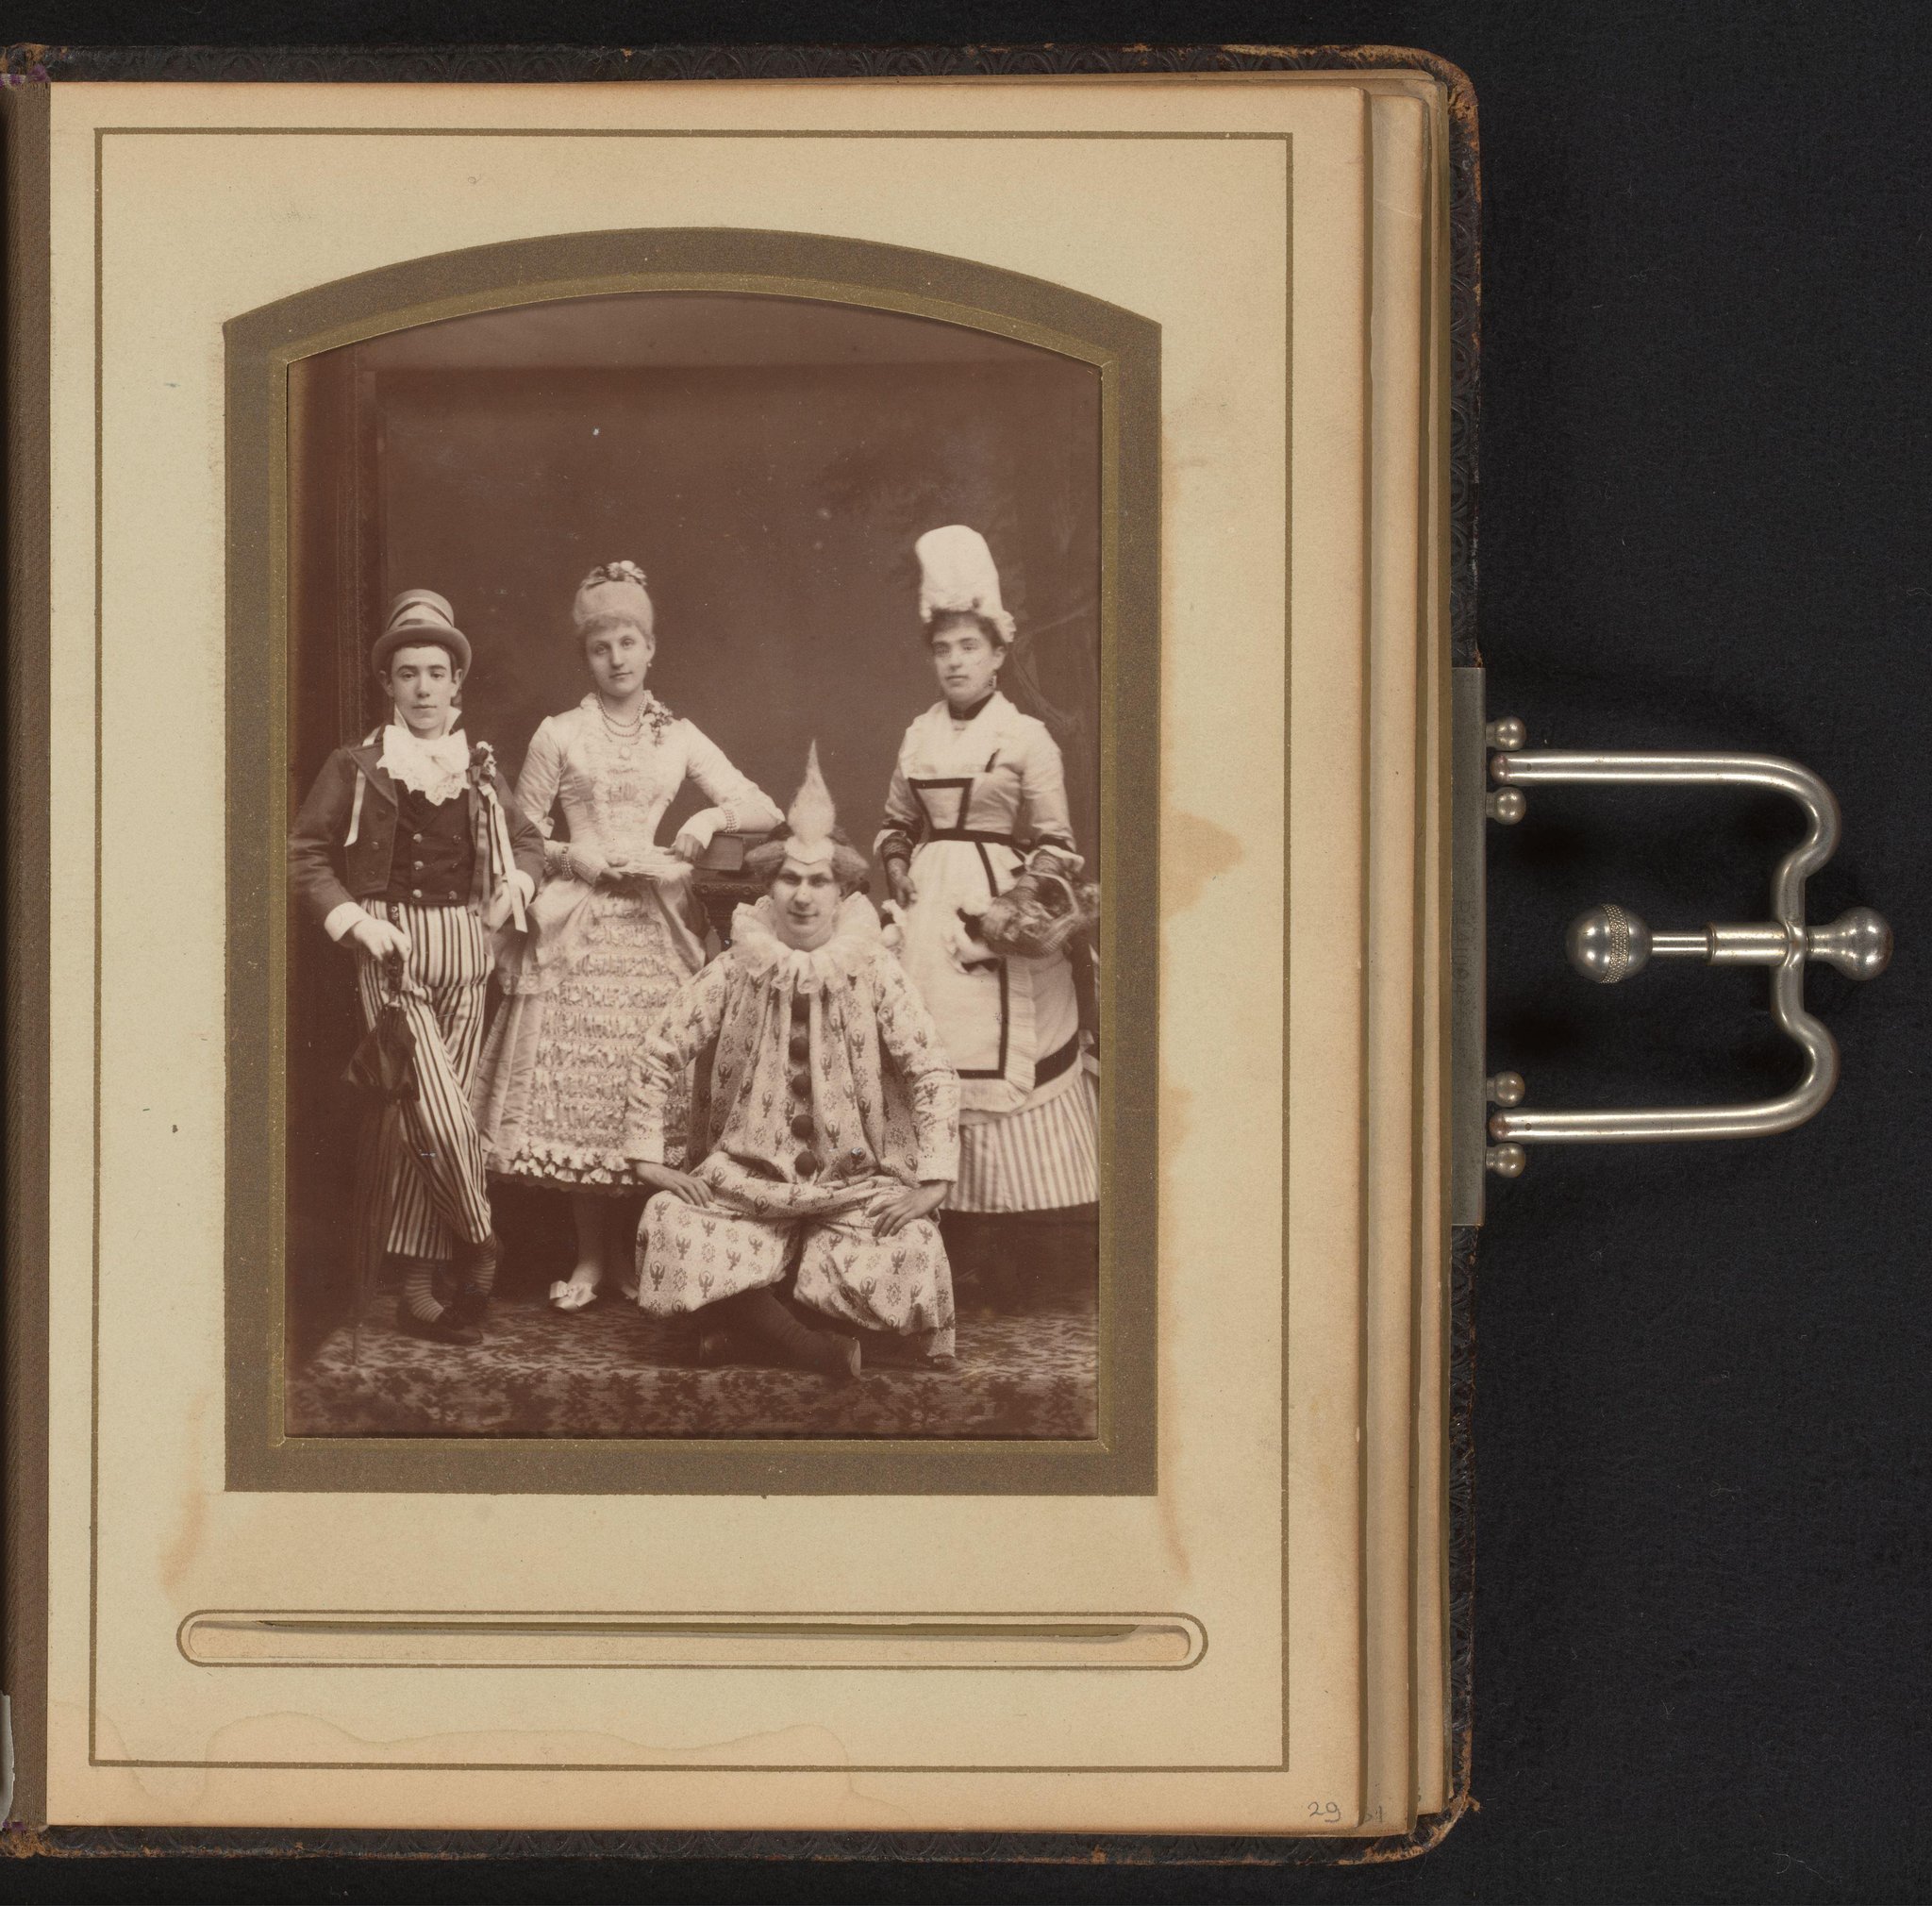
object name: photograph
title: Groepsportret van twee mannen en twee vrouwen in kostuum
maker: eugène huet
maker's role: fotograaf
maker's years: 1839-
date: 1850-1900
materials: cardboard, photographic support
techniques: albumen print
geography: boulogne-sur-seine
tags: adult man (+ two persons), stage costume, adult woman (+ two persons), anonymous historical persons portrayed in a group, in a group-portrait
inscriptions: inscription: ‘EH/ Photographie/ artistique/ E. Huet/ 24, Rue d'Aguesseau/ Boulogne/ (SEINE)/ Tous les clichés sont conservés.’